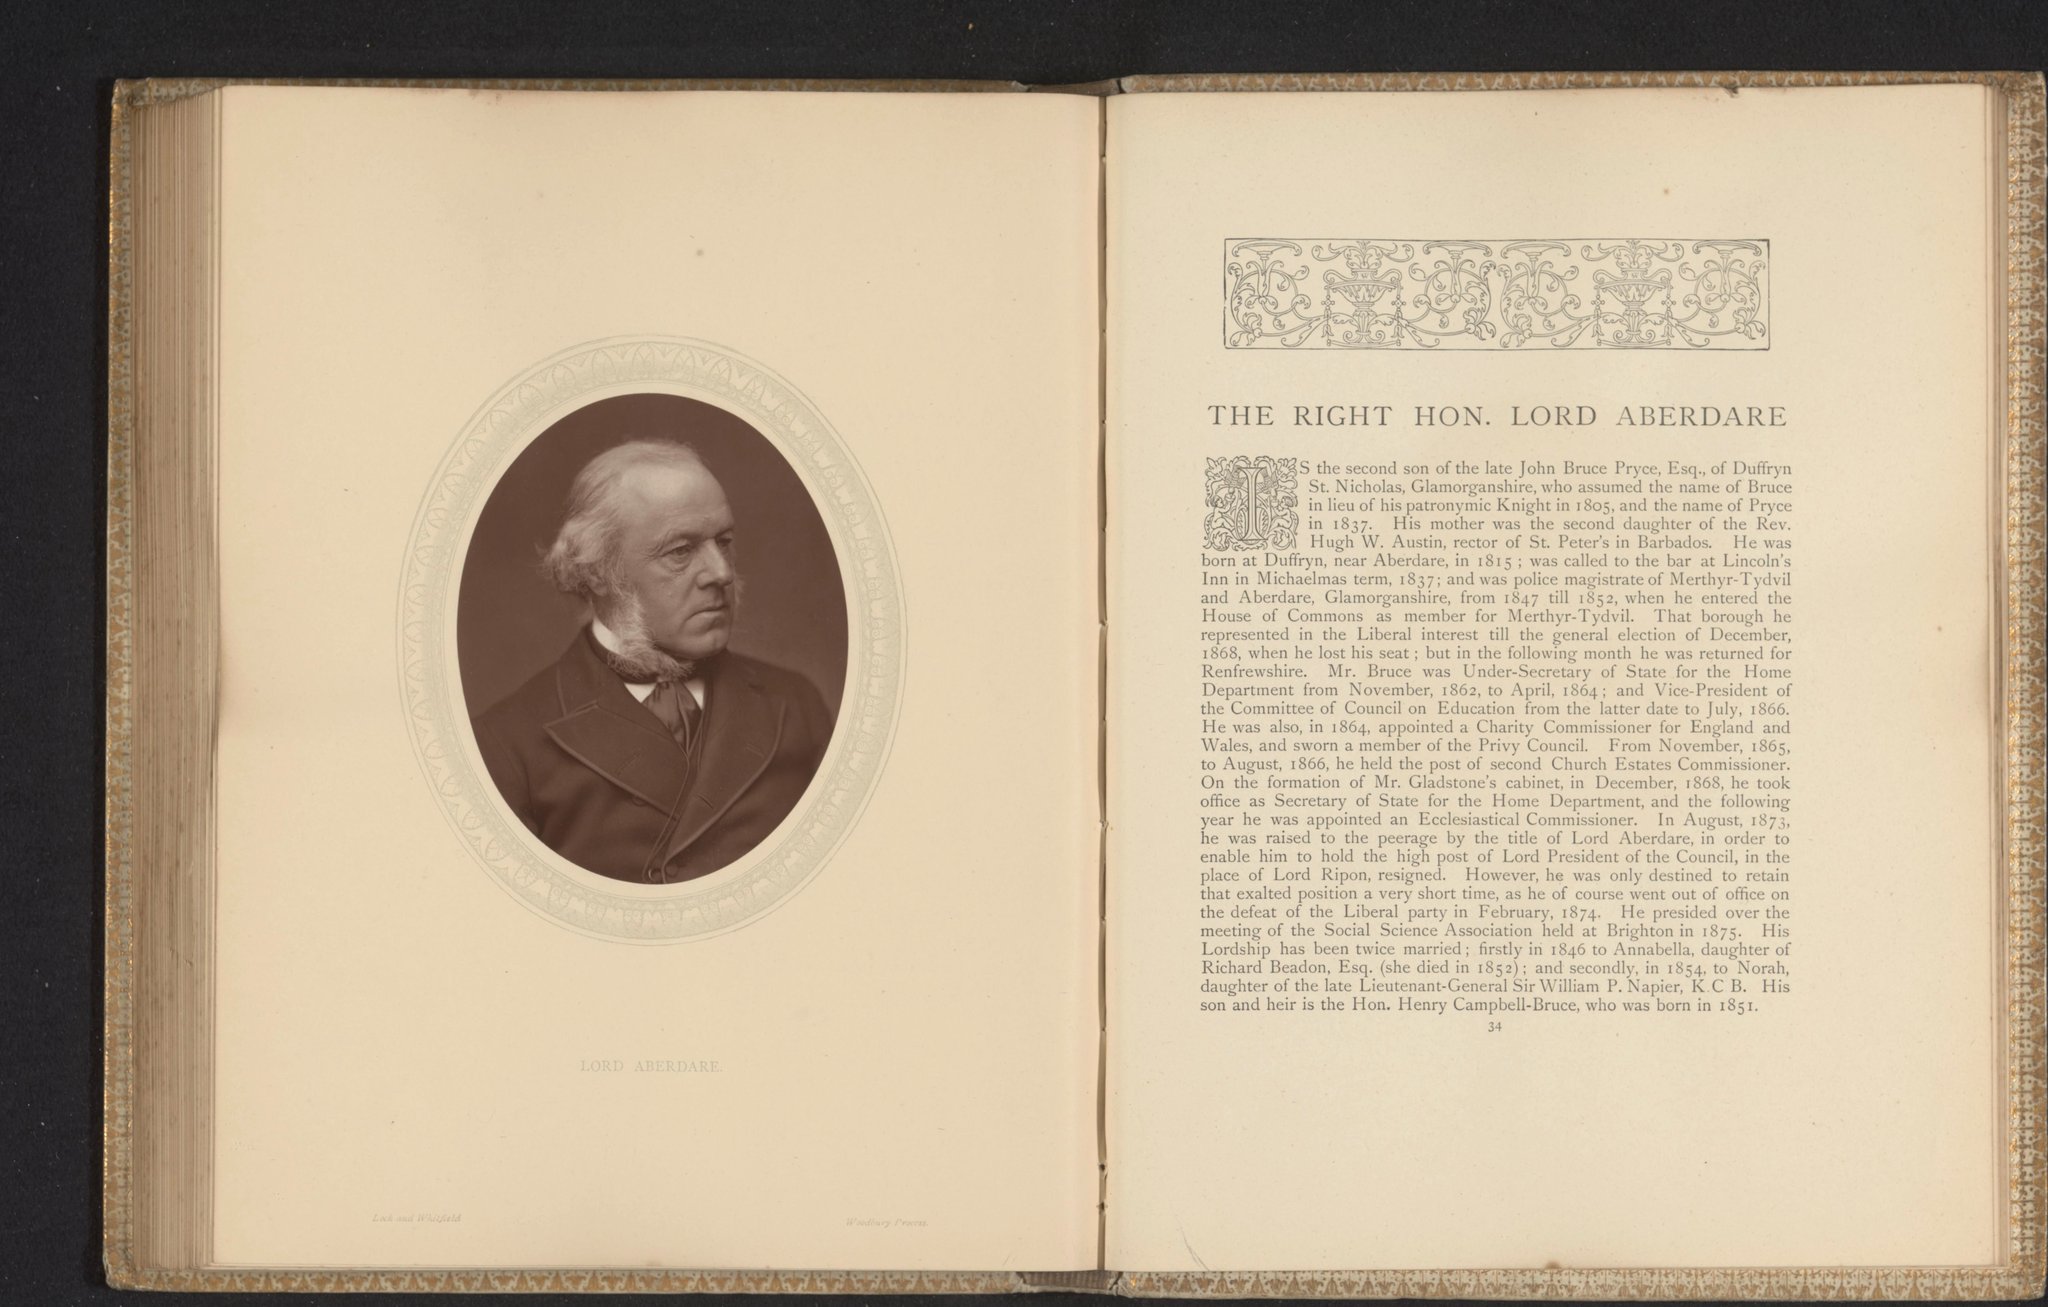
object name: page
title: Lord Aberdare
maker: Anonymous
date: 1877-1882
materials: paper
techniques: woodburytype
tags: politician, historical persons (portraits and scenes from the life) (+ (full) bust portrait), politician, e.g. party leader